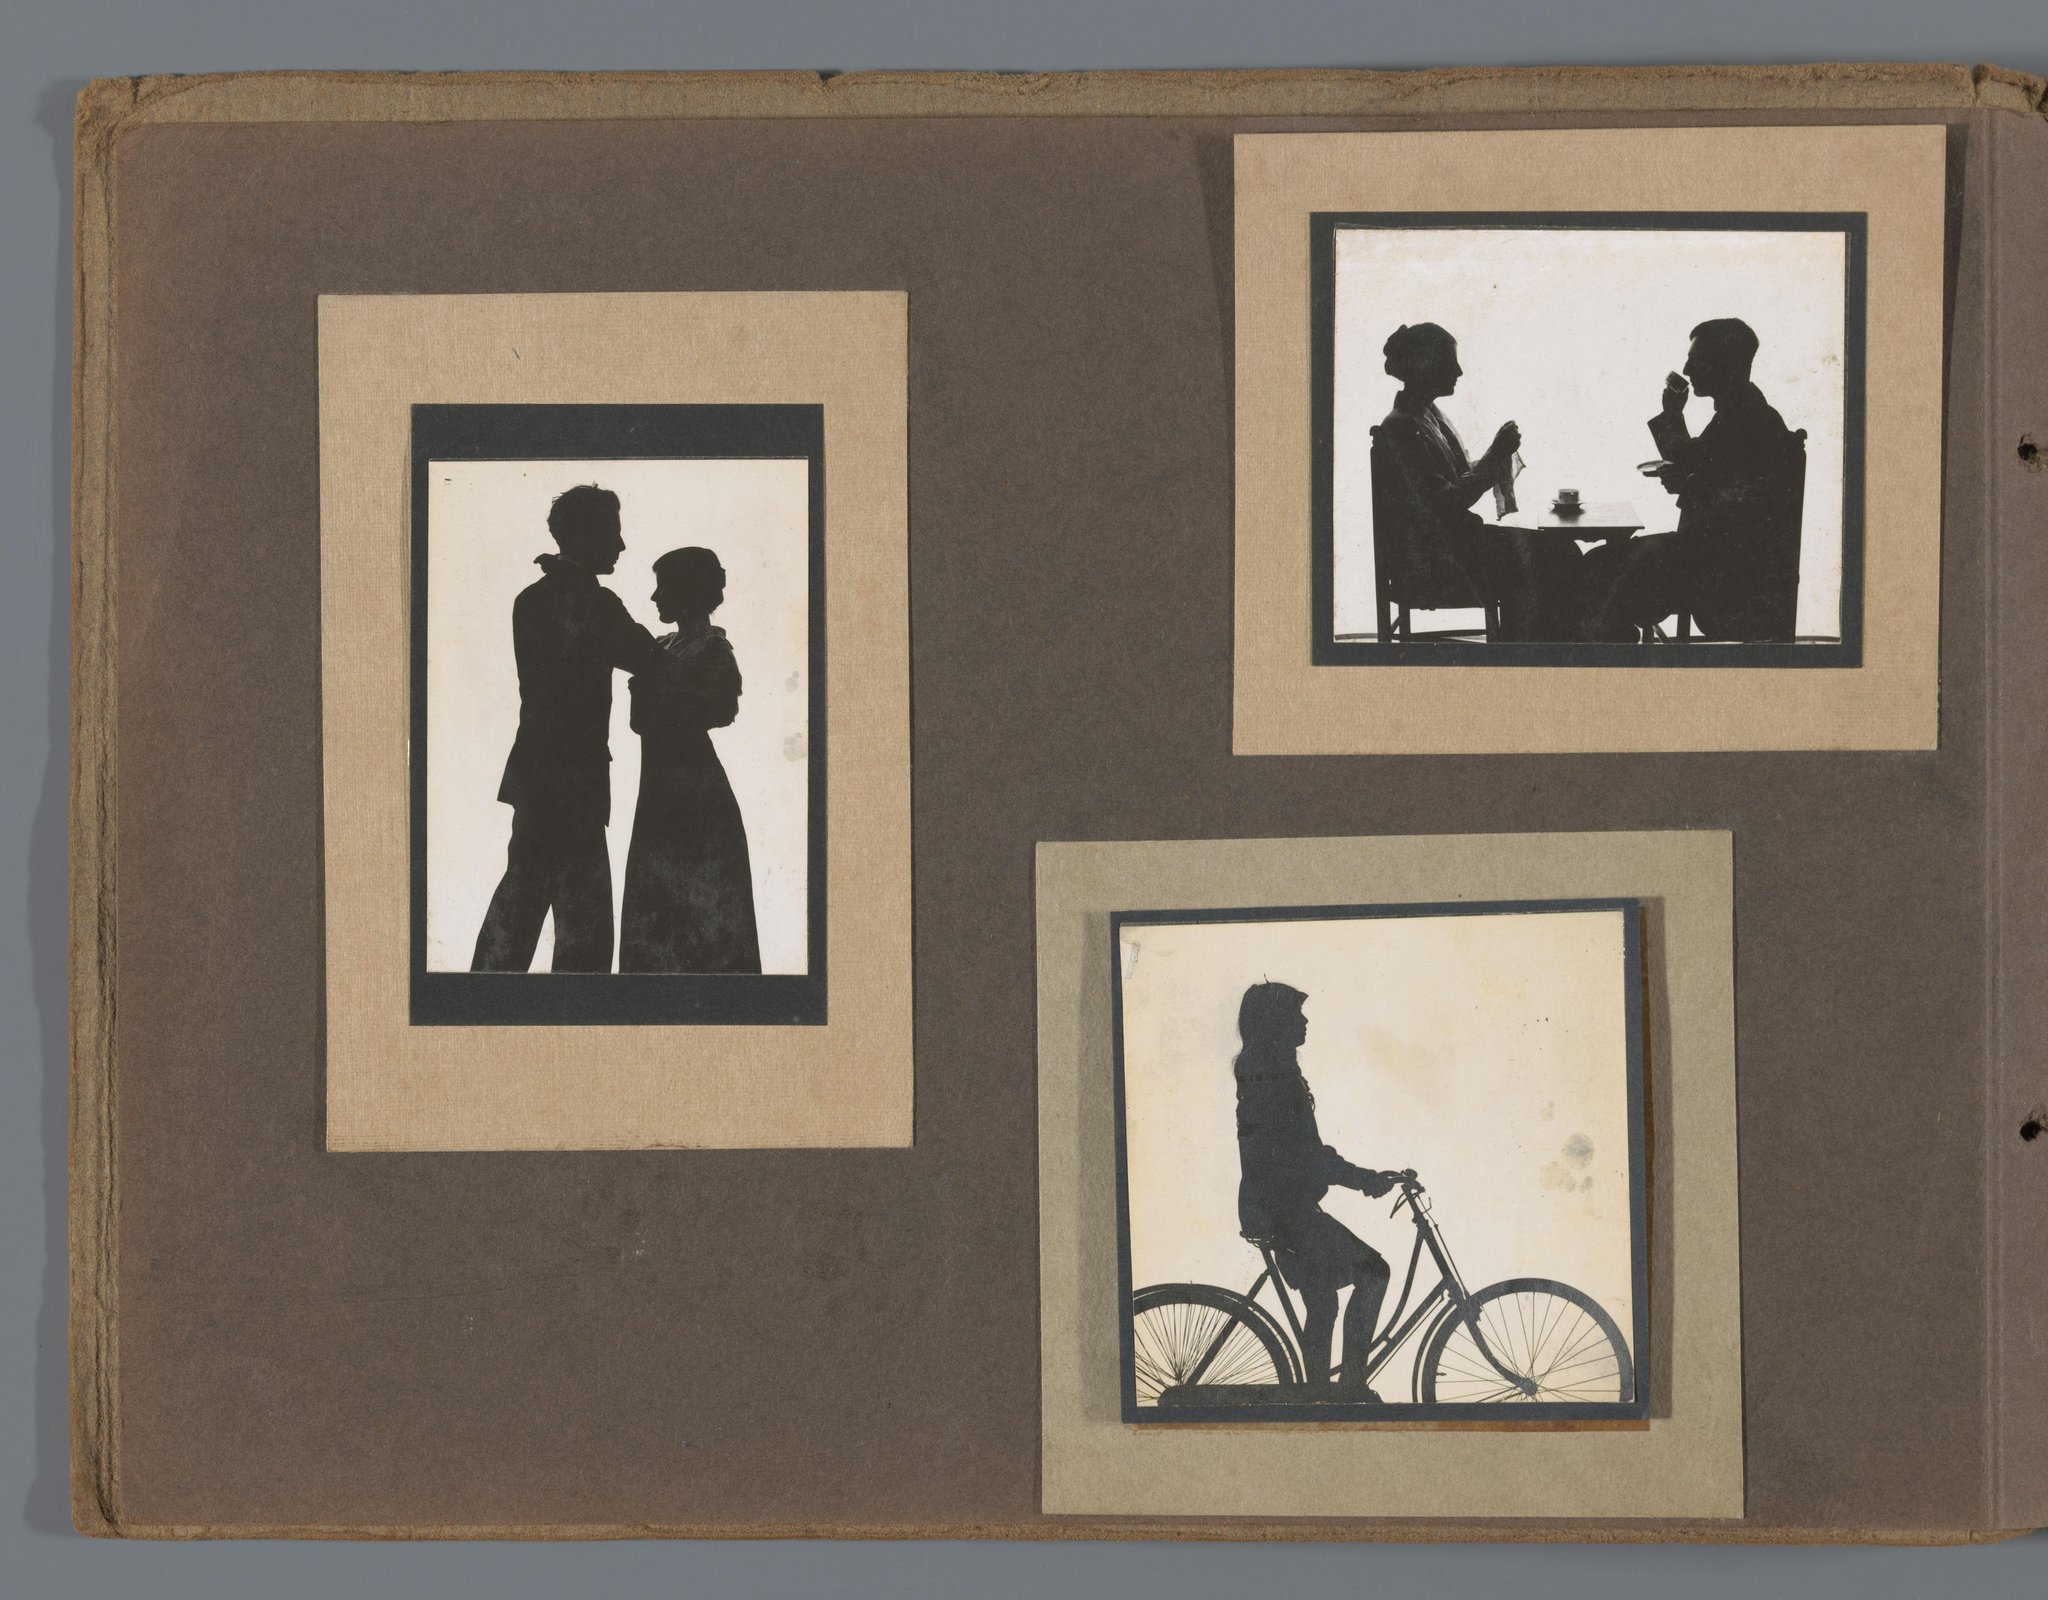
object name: photograph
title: Silhouetfoto's van een dansend paar, twee mensen aan een tafel en een kind op een fiets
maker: carolina frederika onnen (lien/loen)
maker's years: 1896-1983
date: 1914-1915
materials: paper, cardboard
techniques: gelatin silver print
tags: shadow-play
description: Deze foto's zijn onderdeel van een album.